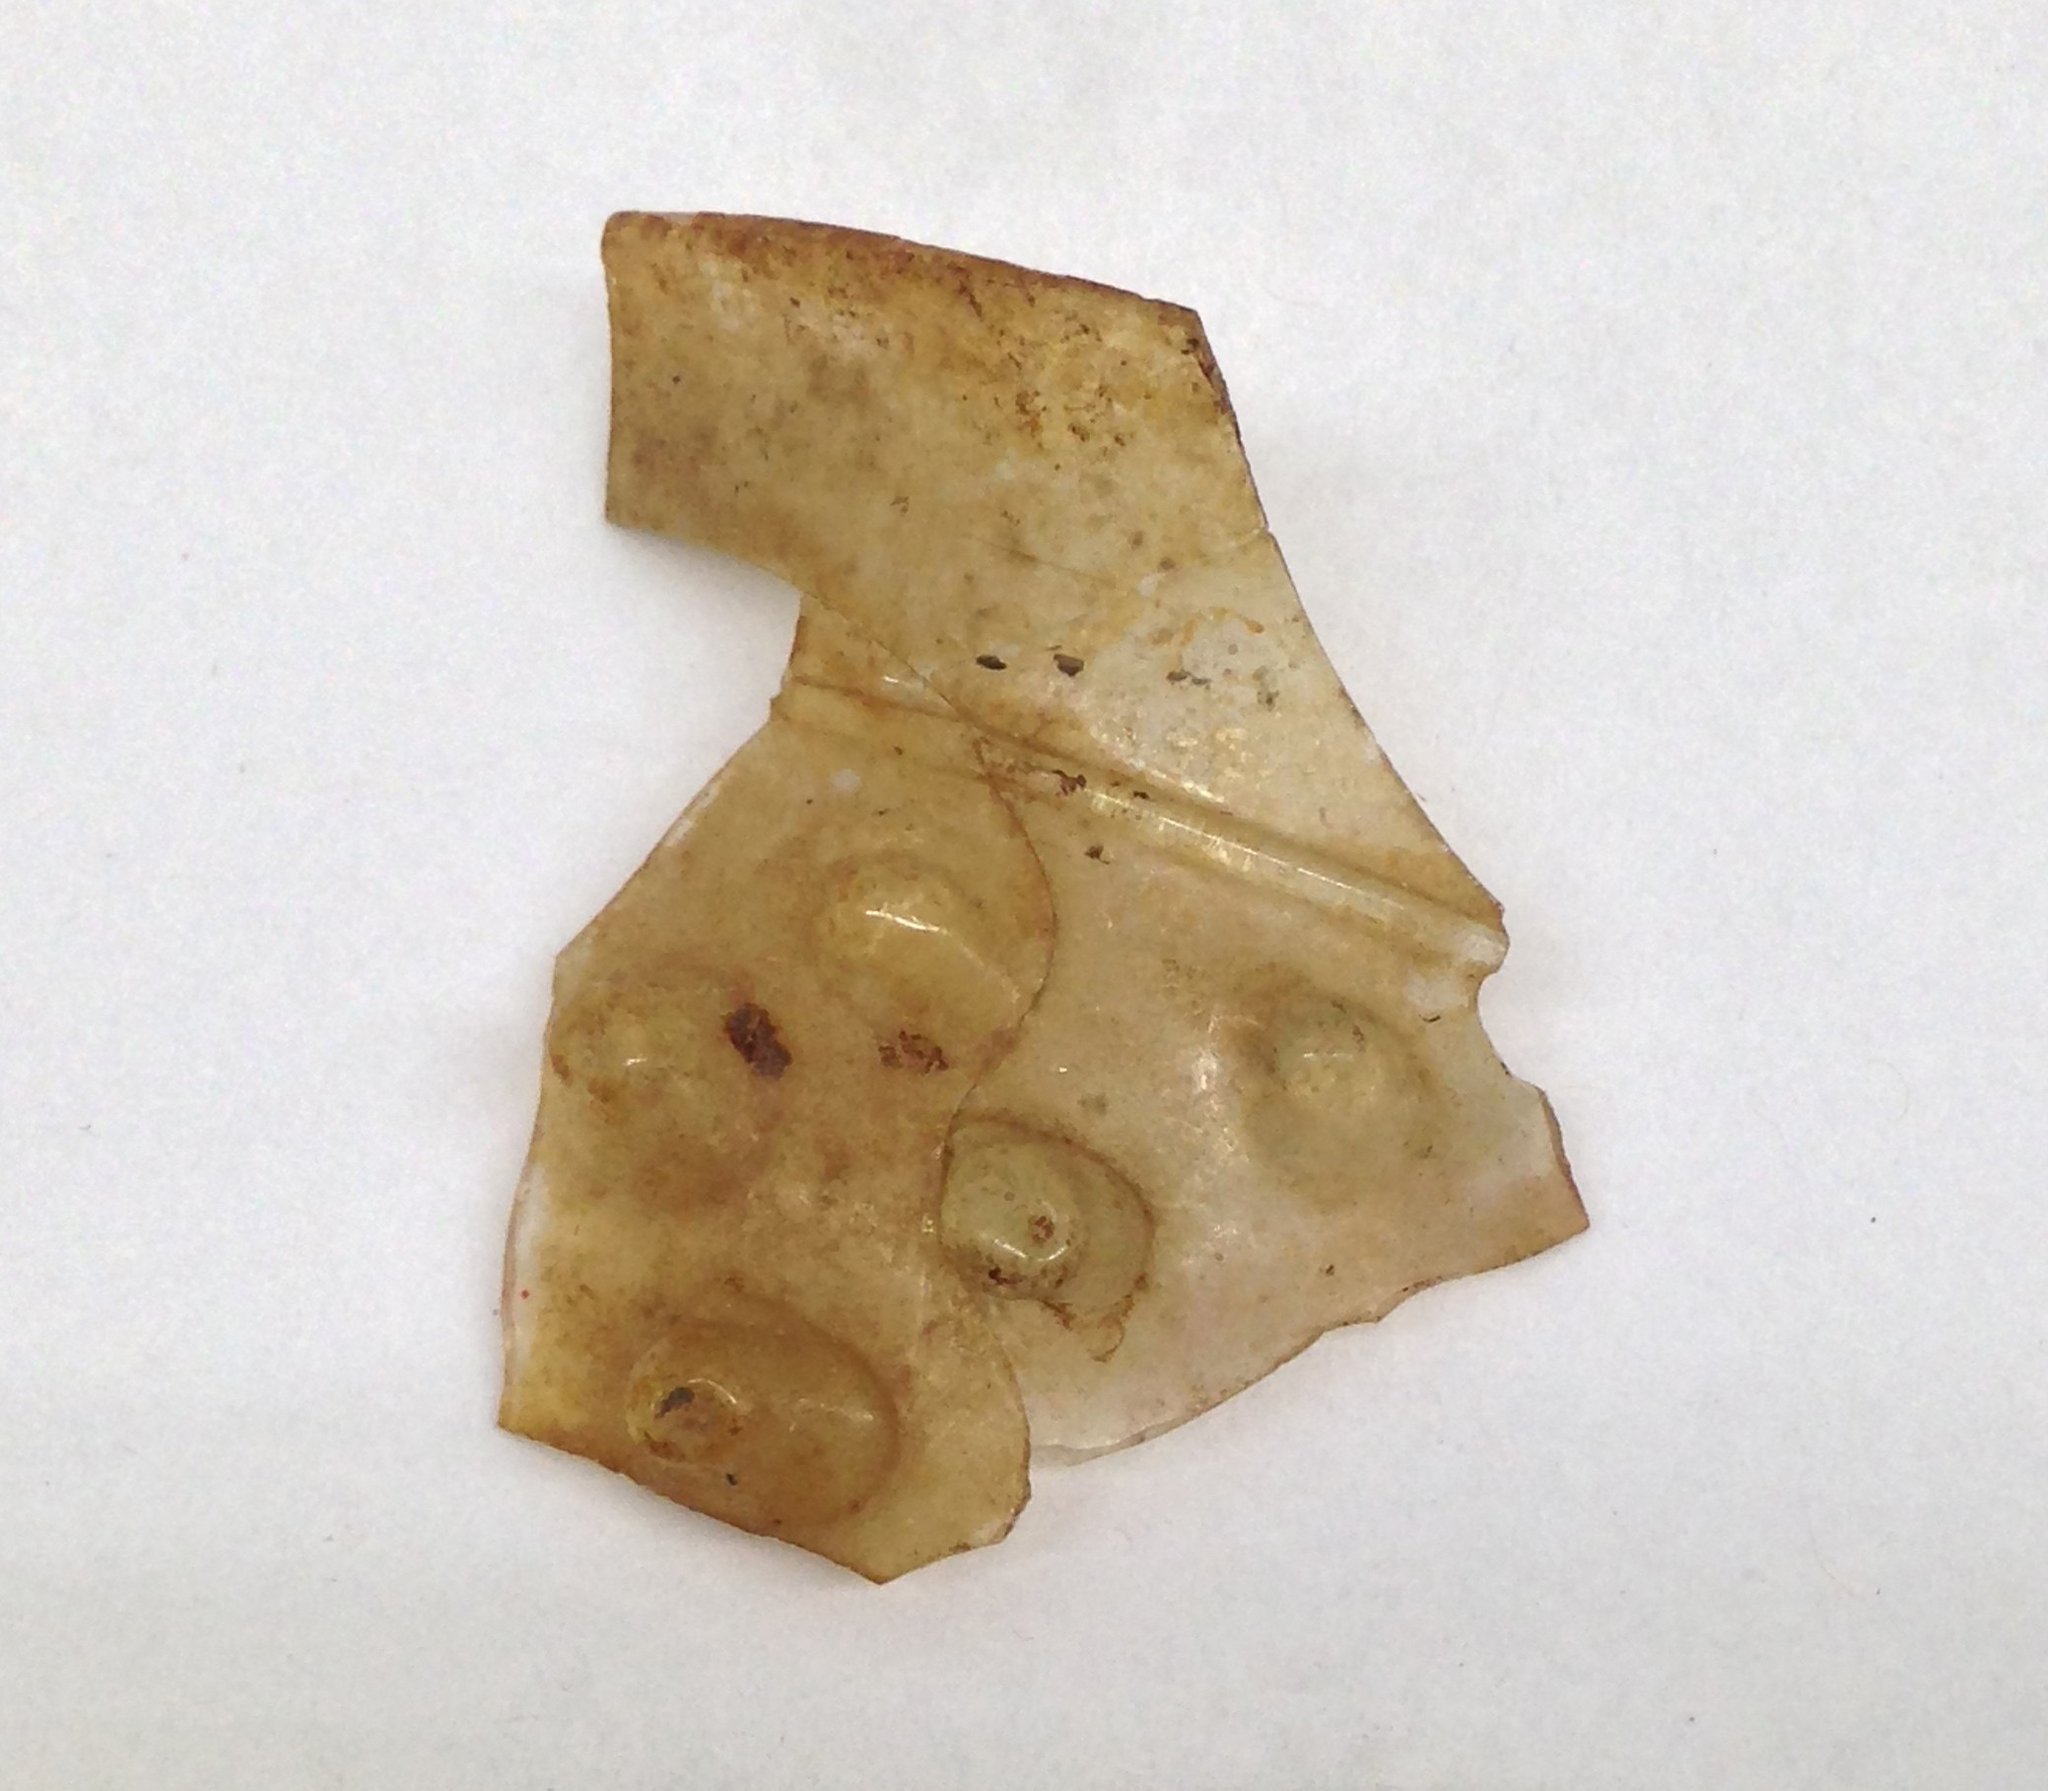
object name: fragment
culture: european or middle eastern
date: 1150-1250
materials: ceramic, glass